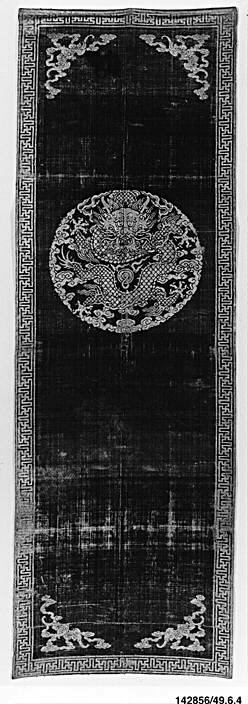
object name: chair strip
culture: chinese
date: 1736-1795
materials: cotton, metal thread, silk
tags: dragons